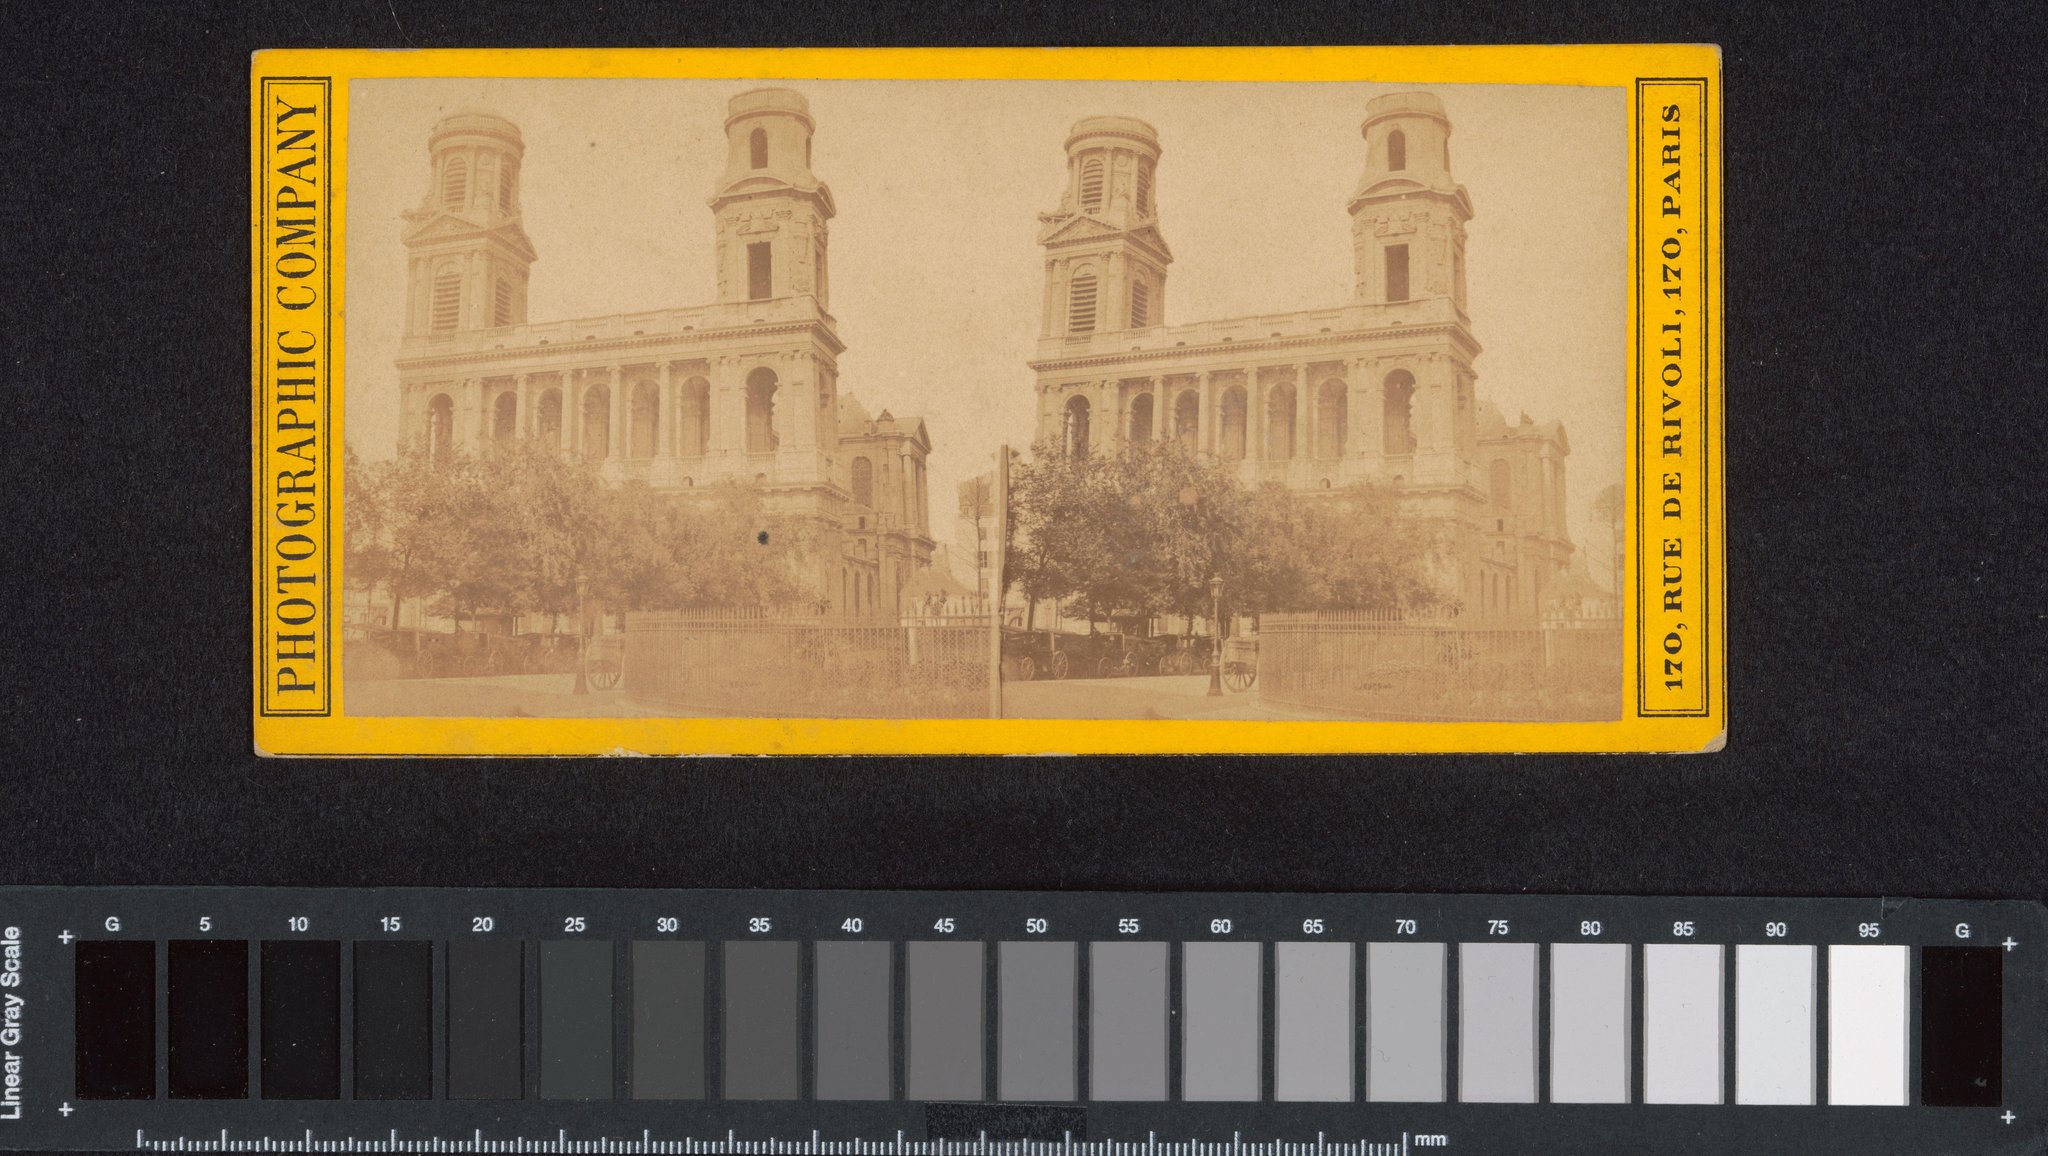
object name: stereograph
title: Gezicht op de Église Saint-Sulpice in Parijs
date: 1850-1880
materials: cardboard, photographic support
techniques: albumen print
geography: paris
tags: church (exterior)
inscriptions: inscription: ‘Eglise St Sulpice’